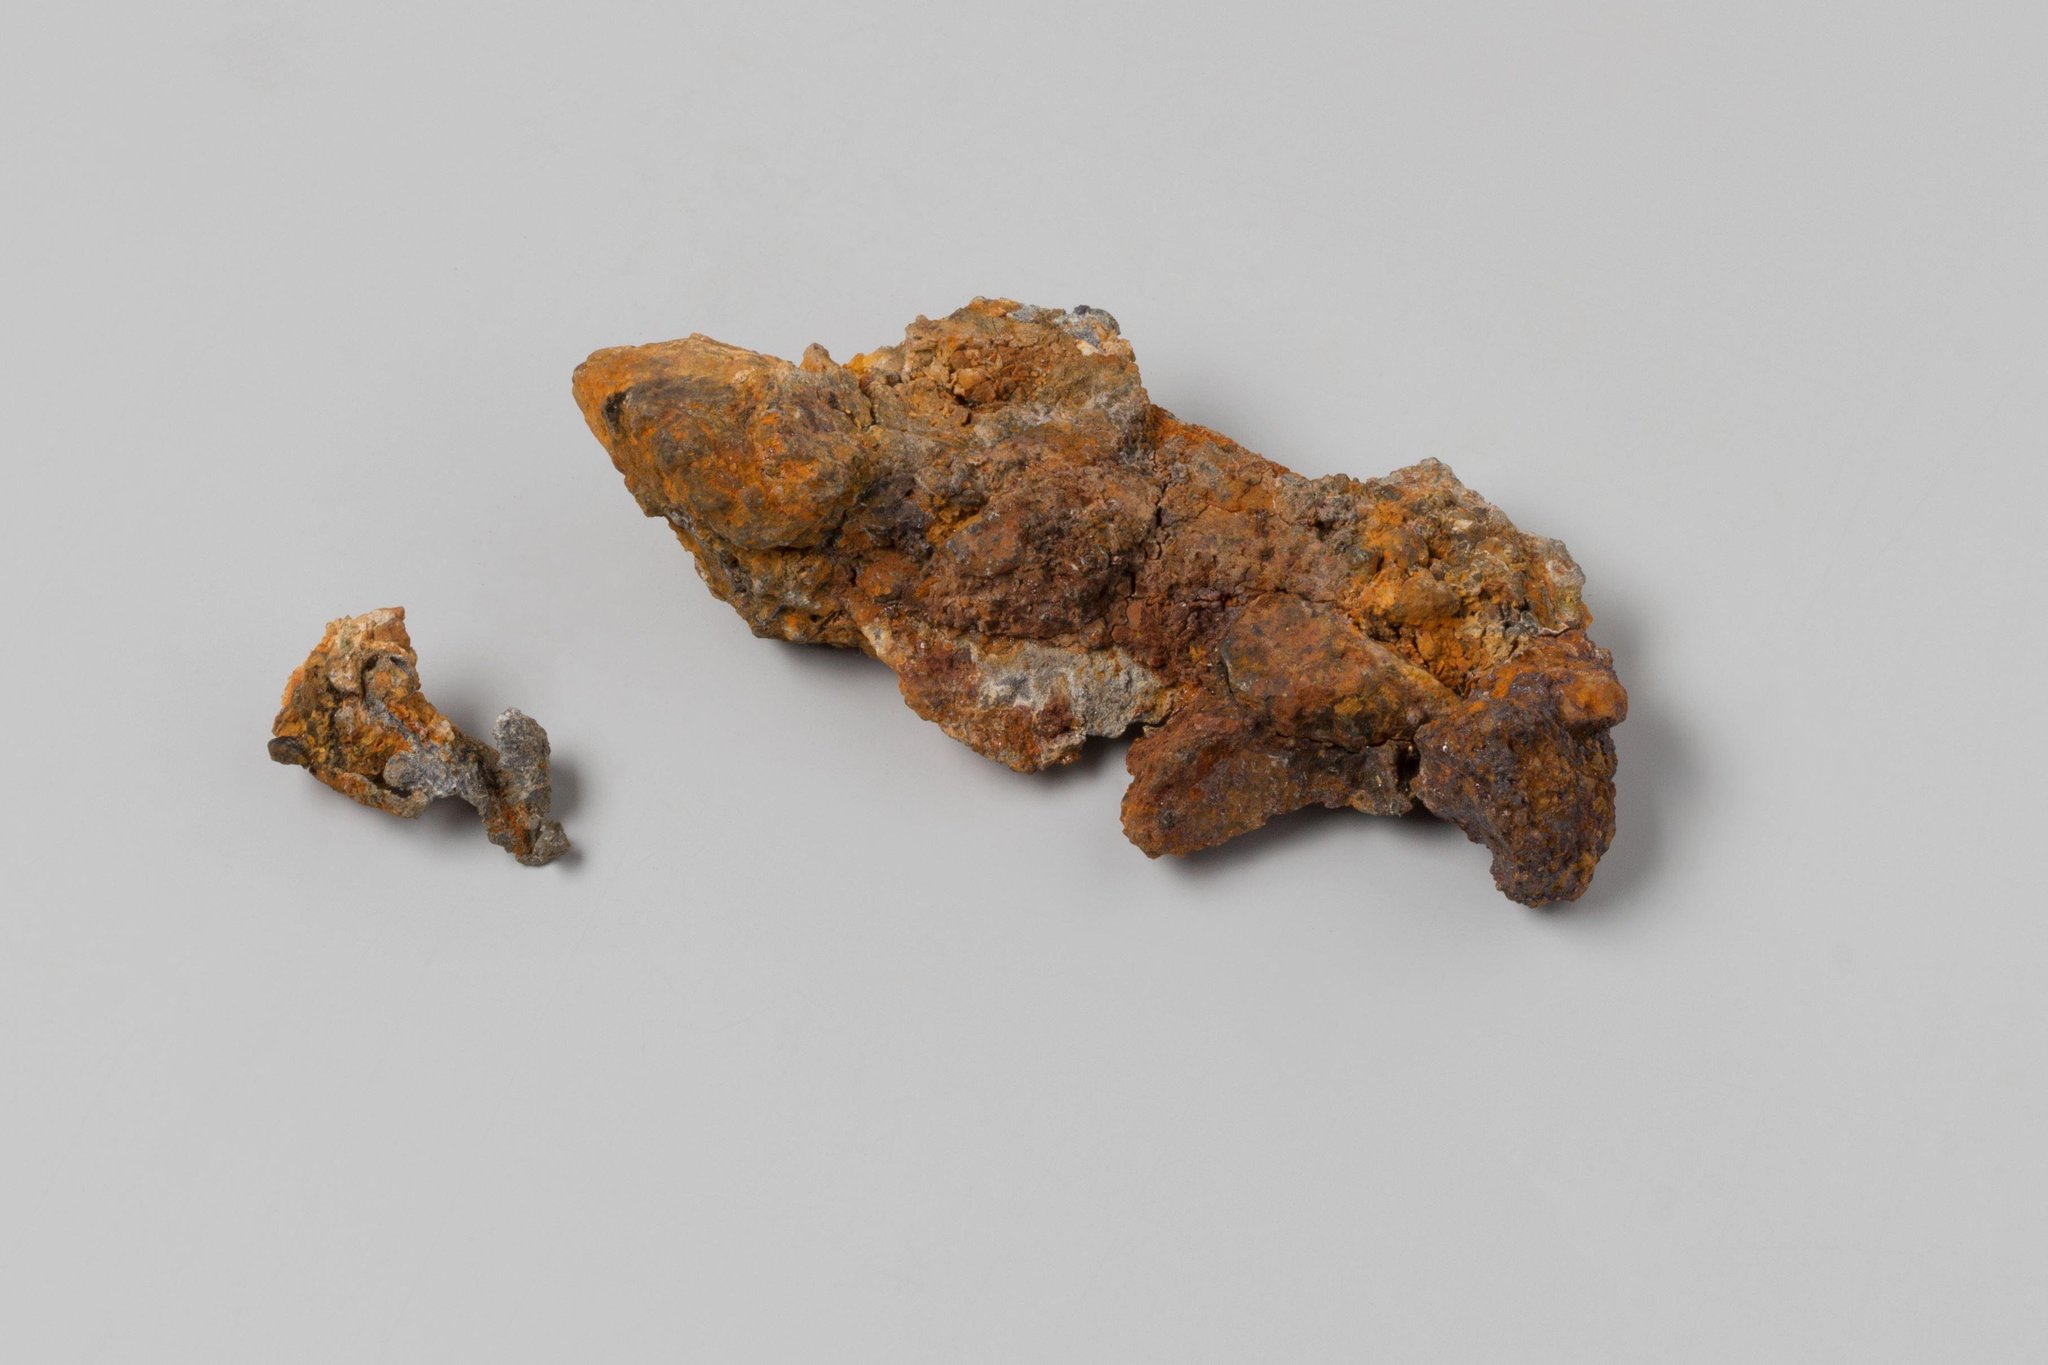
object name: fragment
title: Fragmenten lood met concretie uit het wrak van de Oost-Indiëvaarder Hollandia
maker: Anonymous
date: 1700-1743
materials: stone, lead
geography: netherlands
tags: verenigde oostindische compagnie, hollandia (schip), annet